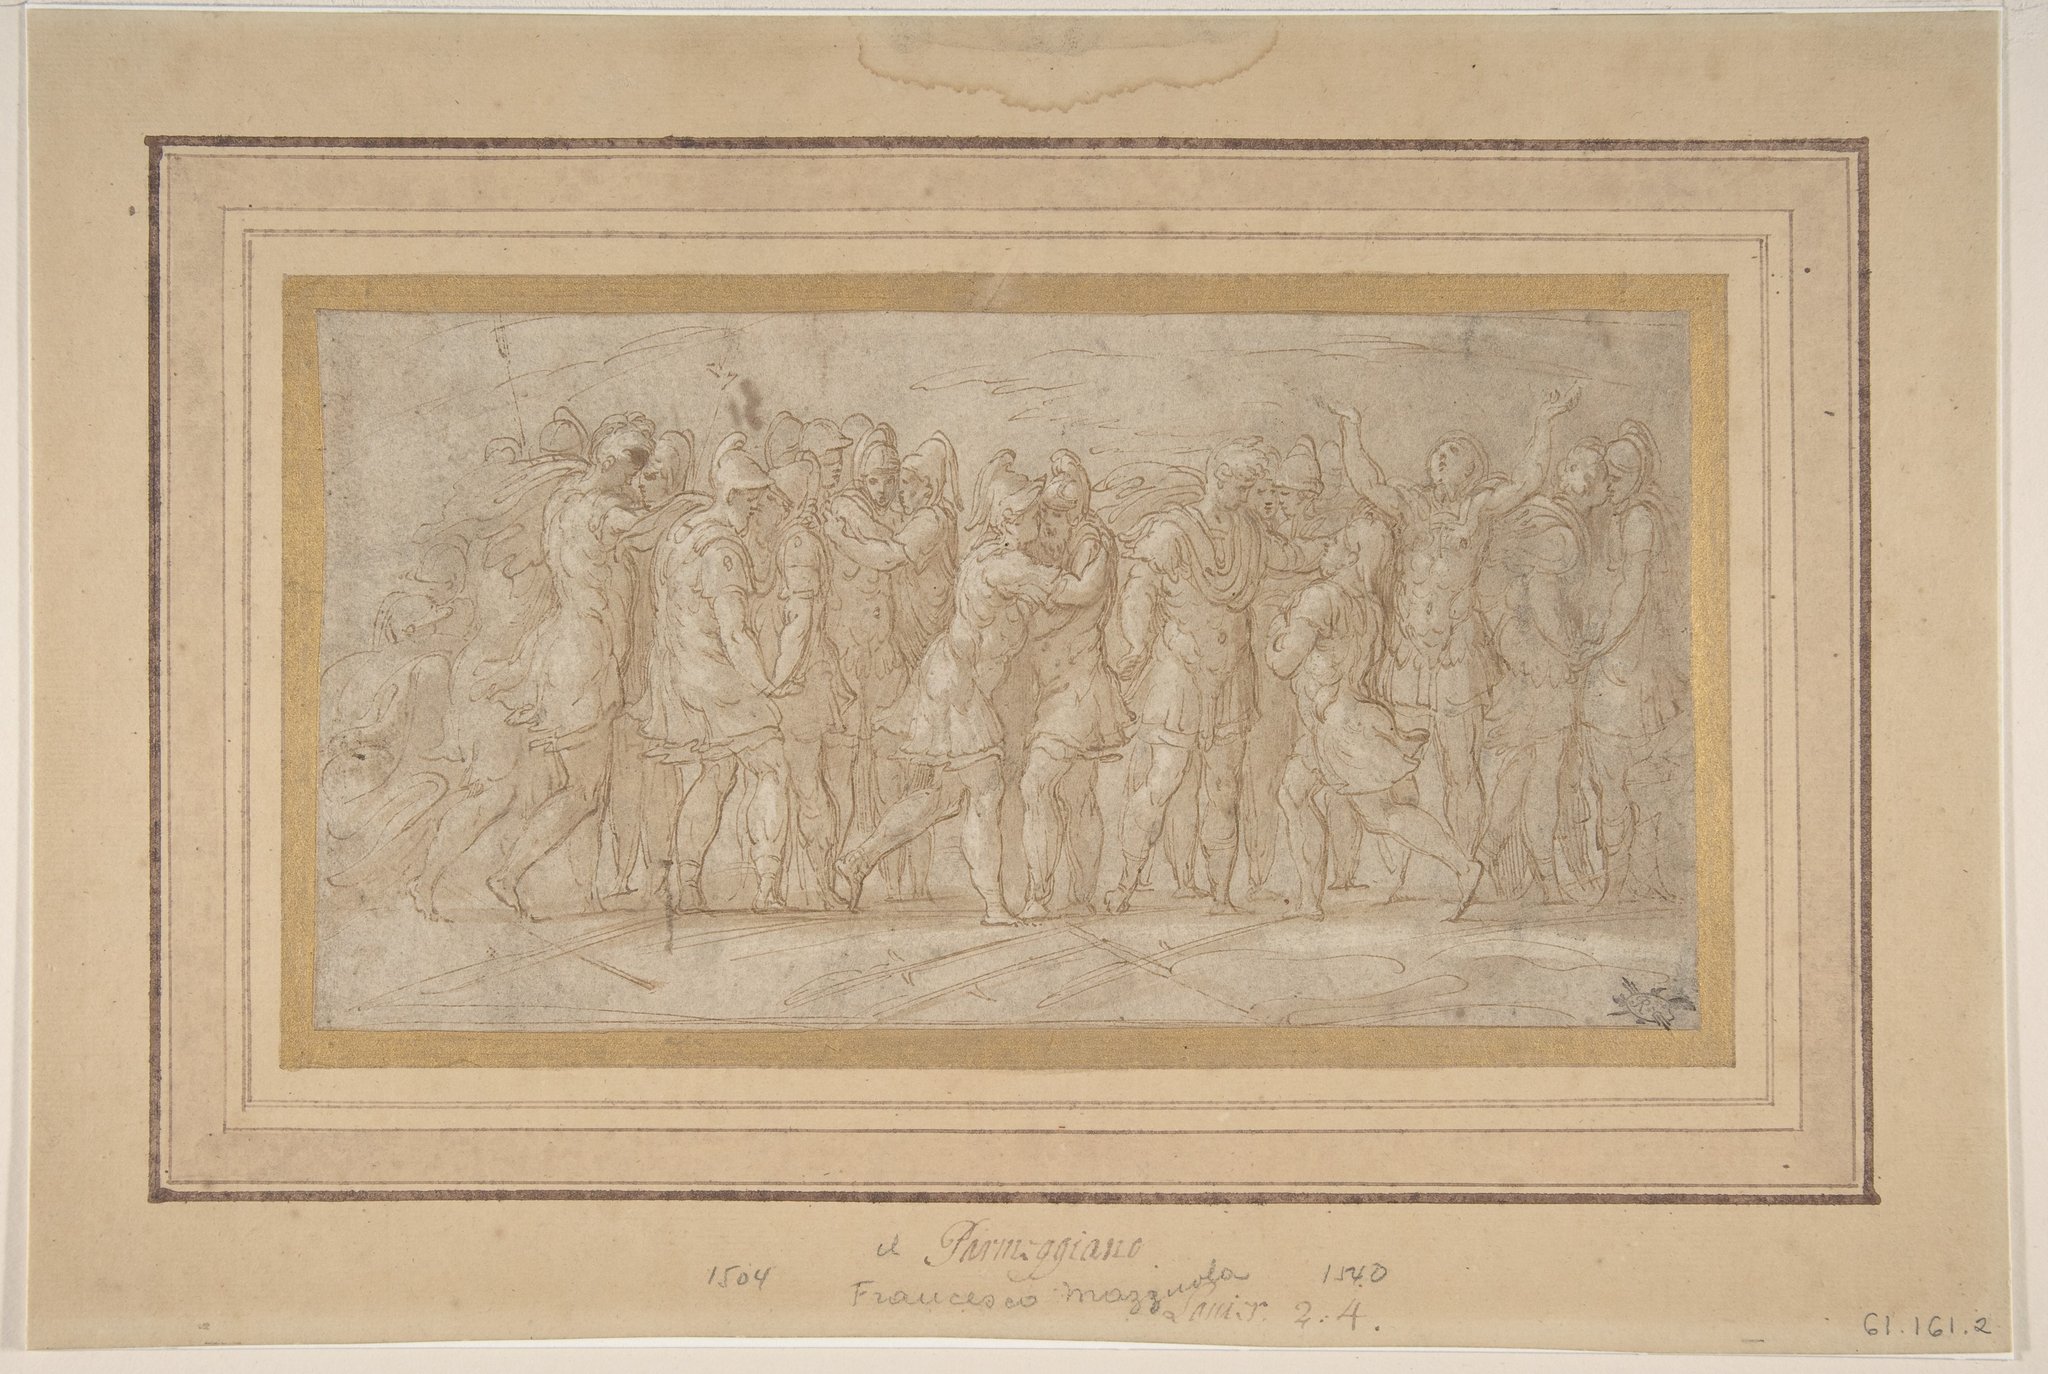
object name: drawing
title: Roman or Greek Warriors Celebrating after a Victory.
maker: parmigianino (girolamo francesco maria mazzola)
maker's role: artist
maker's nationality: italian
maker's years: 1503-1540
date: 1503-1540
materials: gouache, ink, paper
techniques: brush, highlighting, pen, wash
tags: soldiers,men